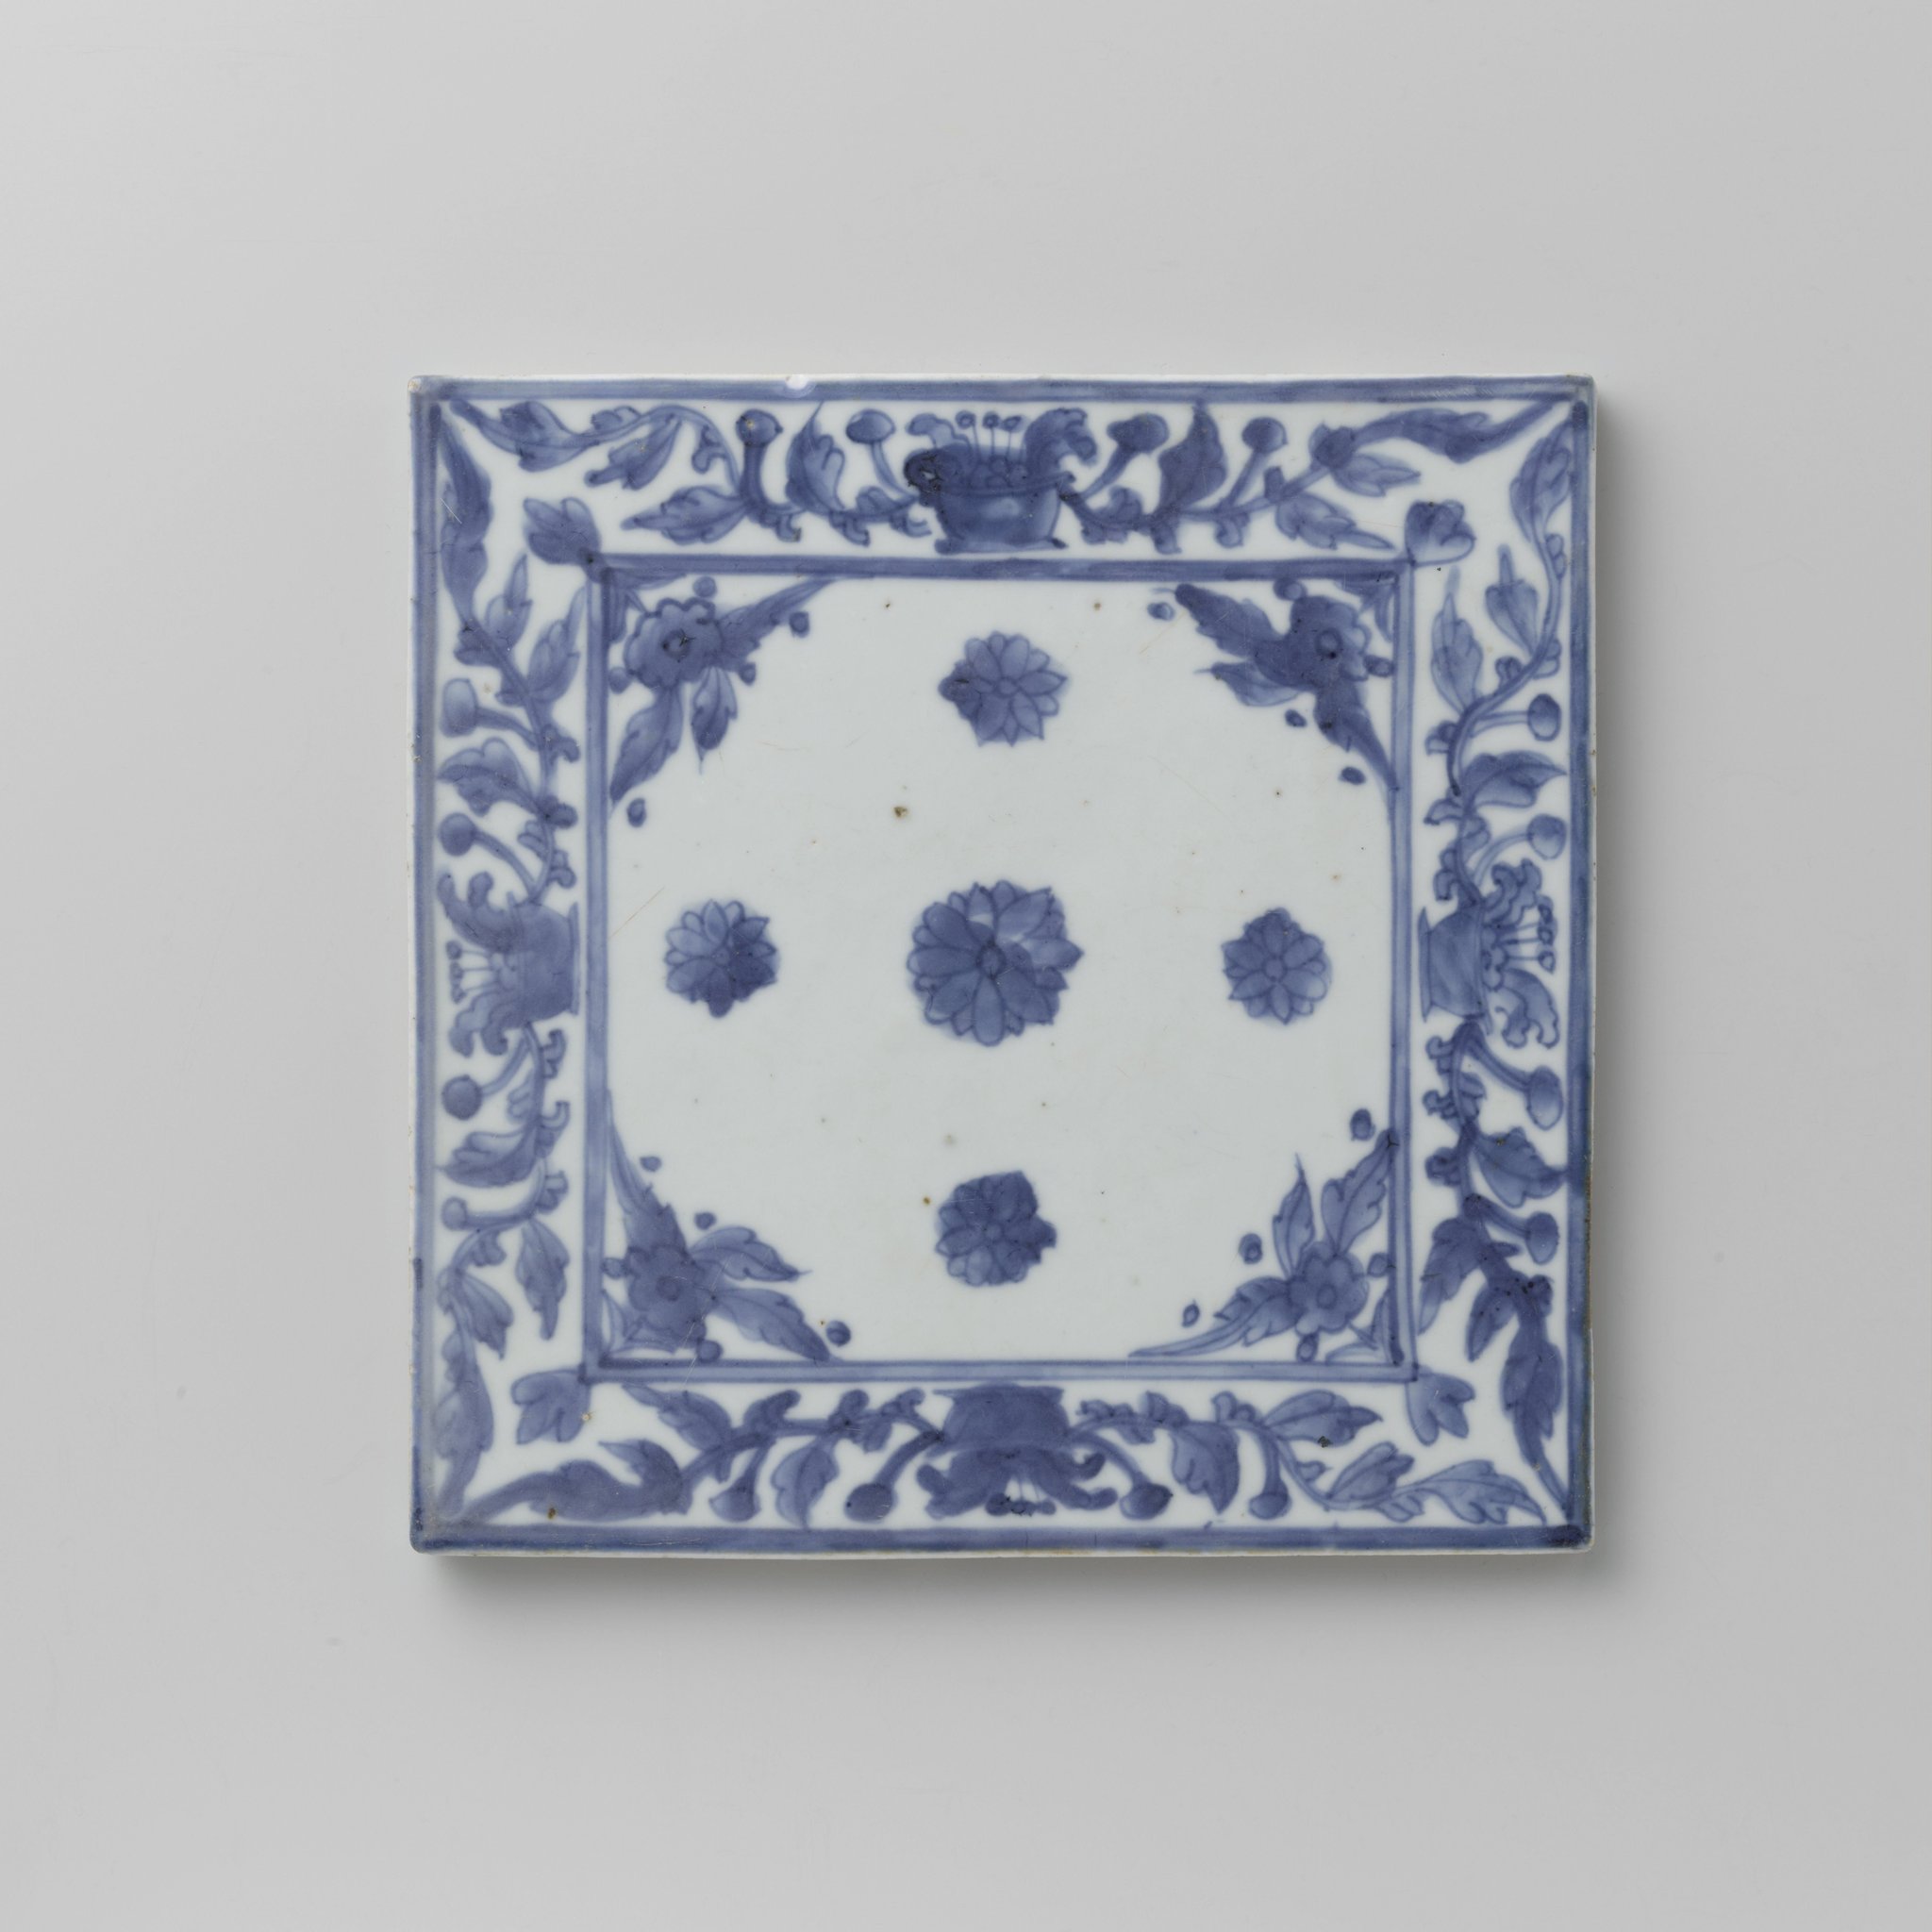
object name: tile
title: Tile with roundels in a square panel and scrolls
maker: Anonymous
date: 1700-1725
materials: cobalt, glaze, paint, porcelain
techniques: firing, forming, vitrification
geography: china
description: Tegel van porselein, beschilderd in onderglazuur blauw. In een vierkant cartouche een grote en vier kleinere bloemrozetten, in de hoeken bloemranken; hieromheen een band met vier bloempotten met aan weerszijden ranken. Een chip in de rand. Blauw-wit.